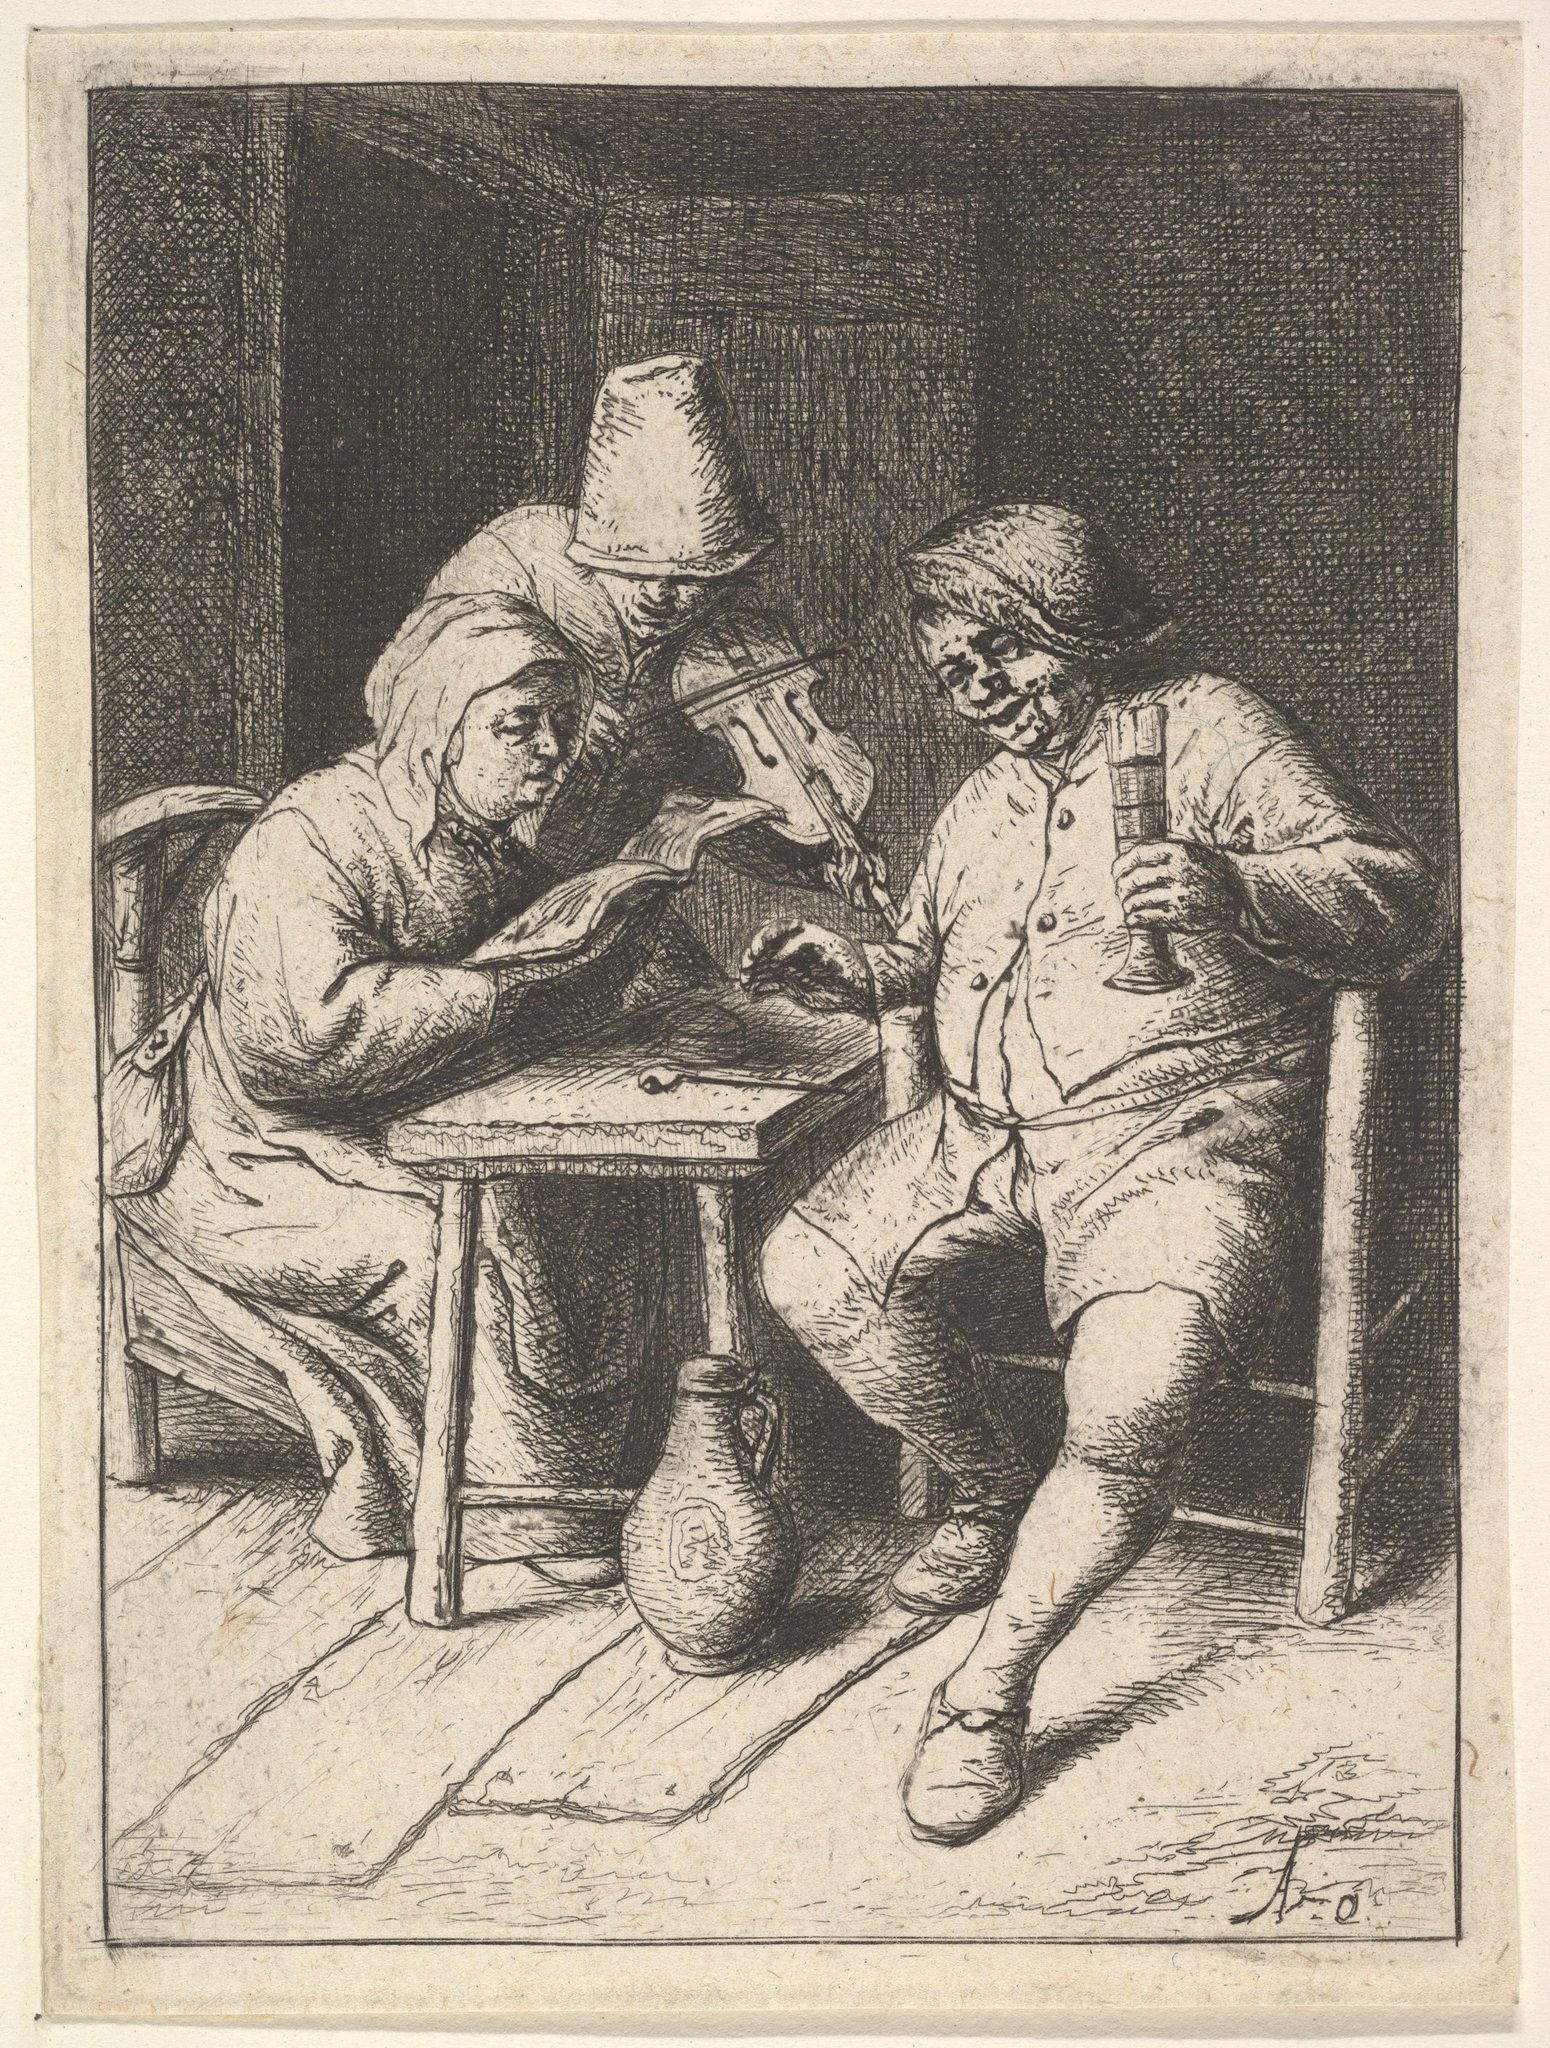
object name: print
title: Singing Couples and Violin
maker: adriaen van ostade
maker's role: artist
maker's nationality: dutch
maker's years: 1610-1685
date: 1610-1685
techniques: etching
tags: couples,men,women,singing,violins